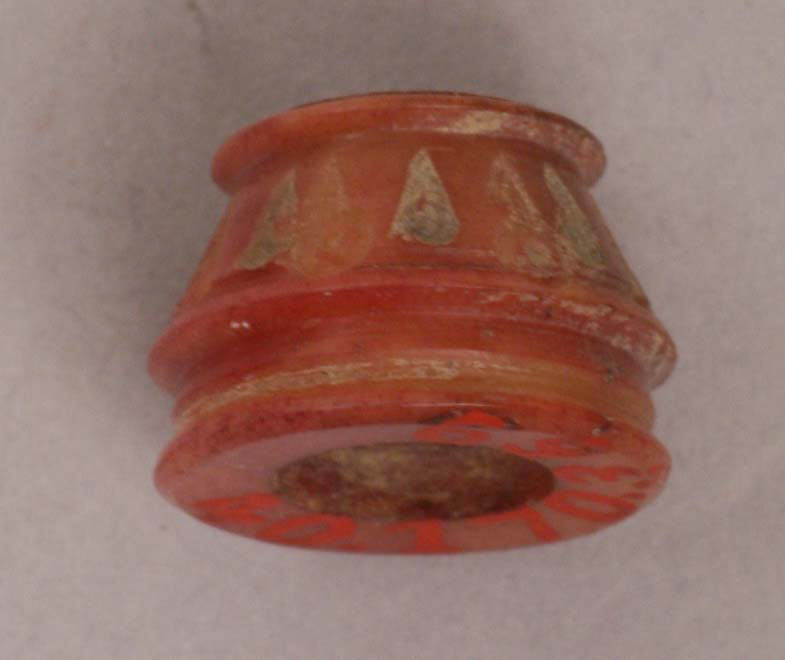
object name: button or bead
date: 801-1000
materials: bone, paint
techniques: incising, inlay, tinting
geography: iran